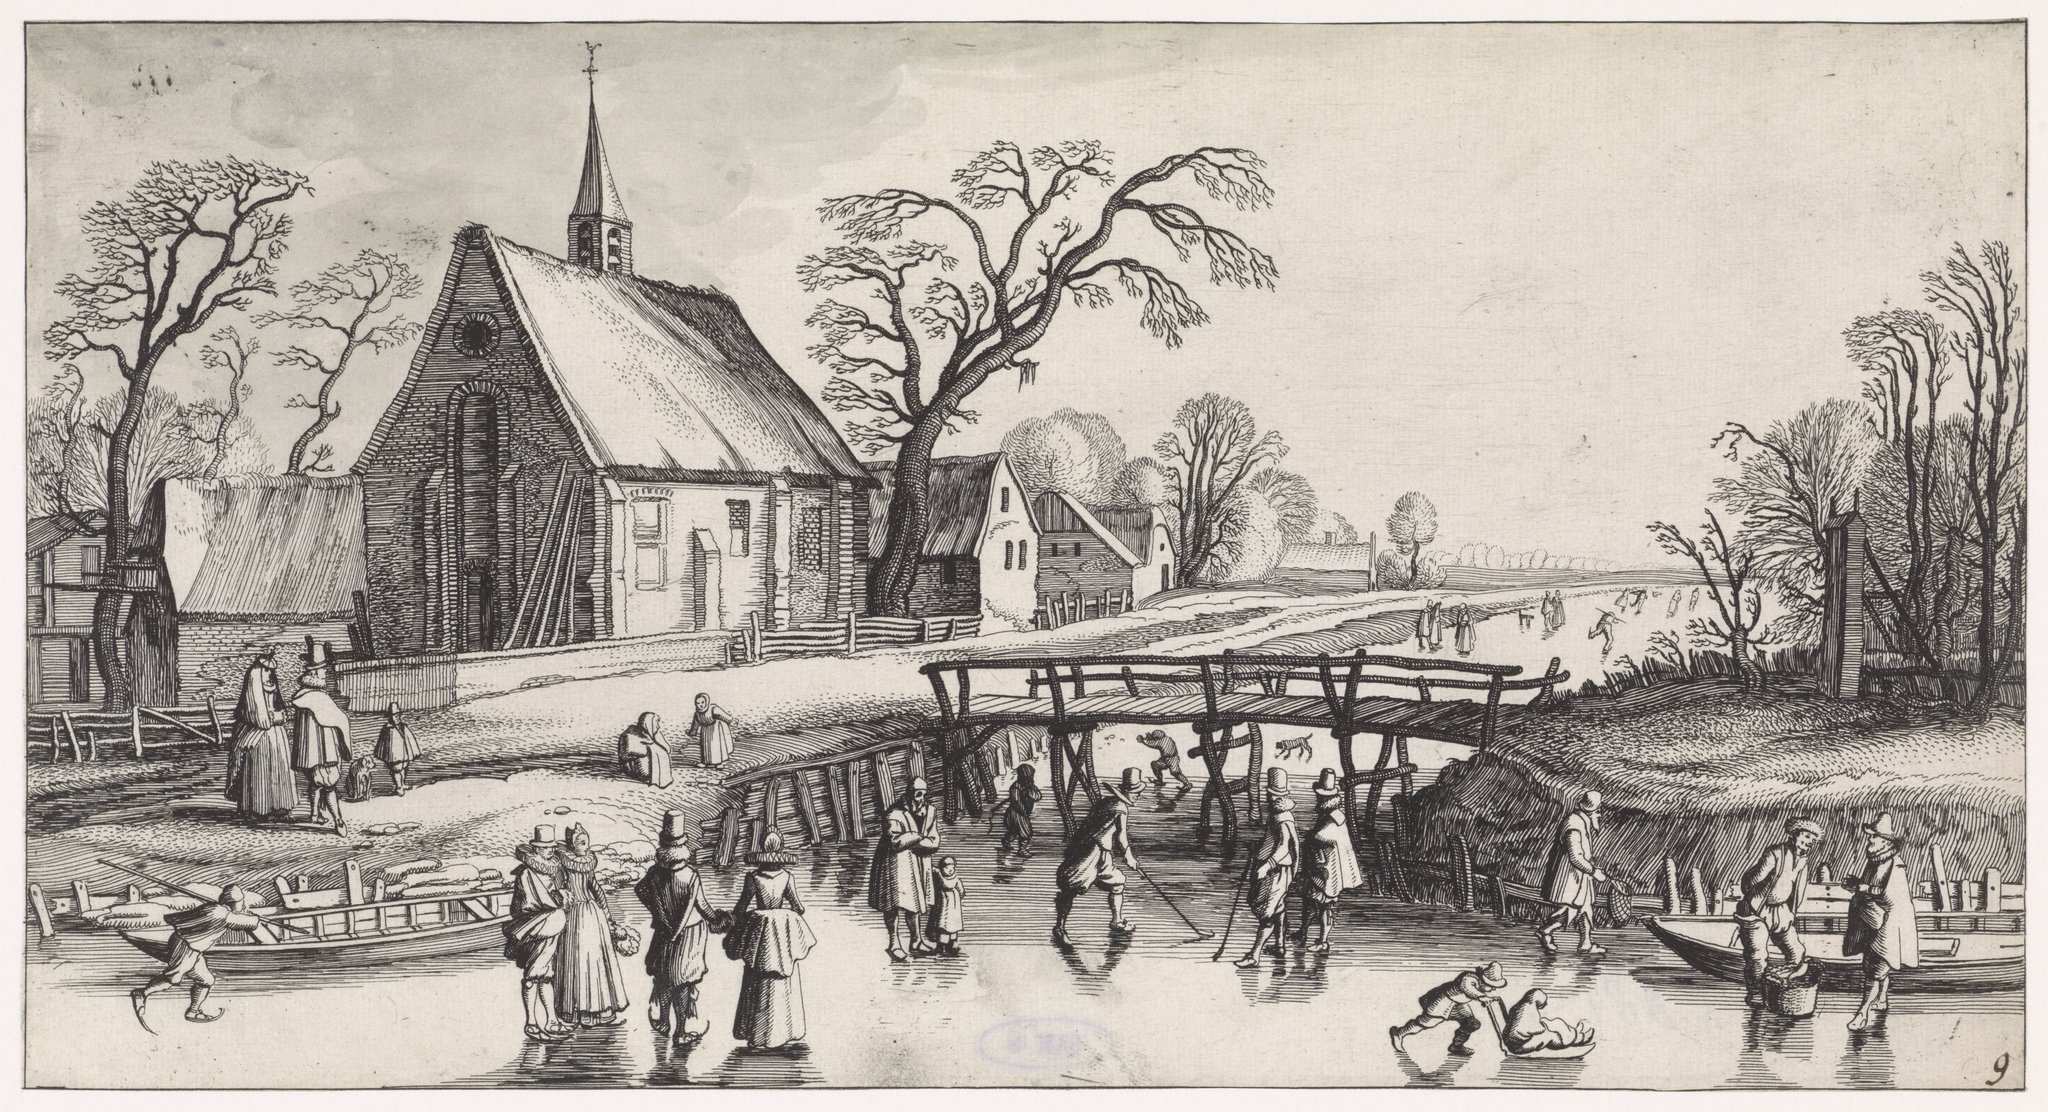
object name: print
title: Winterlandschap met schaatsers bij een dorp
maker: jan van de velde (ii)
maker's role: draughtsman, painter, print maker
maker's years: 1593-1641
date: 1639-1641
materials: ink, paper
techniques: brush, etching, pen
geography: northern netherlands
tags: wooden container: barrel, cask, bucket, tent, kitchen-fire - cc - in the open air, table, hotel, hostelry, inn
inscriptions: number: ‘9’, collector's mark: Lugt 2228, collector's mark: Lugt 1120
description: Winterlandschap met schaatsers bij een dorp. In het midden een houten brug. Op de voorgrond kinderen met een slee en een groep kolfspelers. Negende prent van een serie met 36 prenten van landschappen, verdeeld over zes delen.